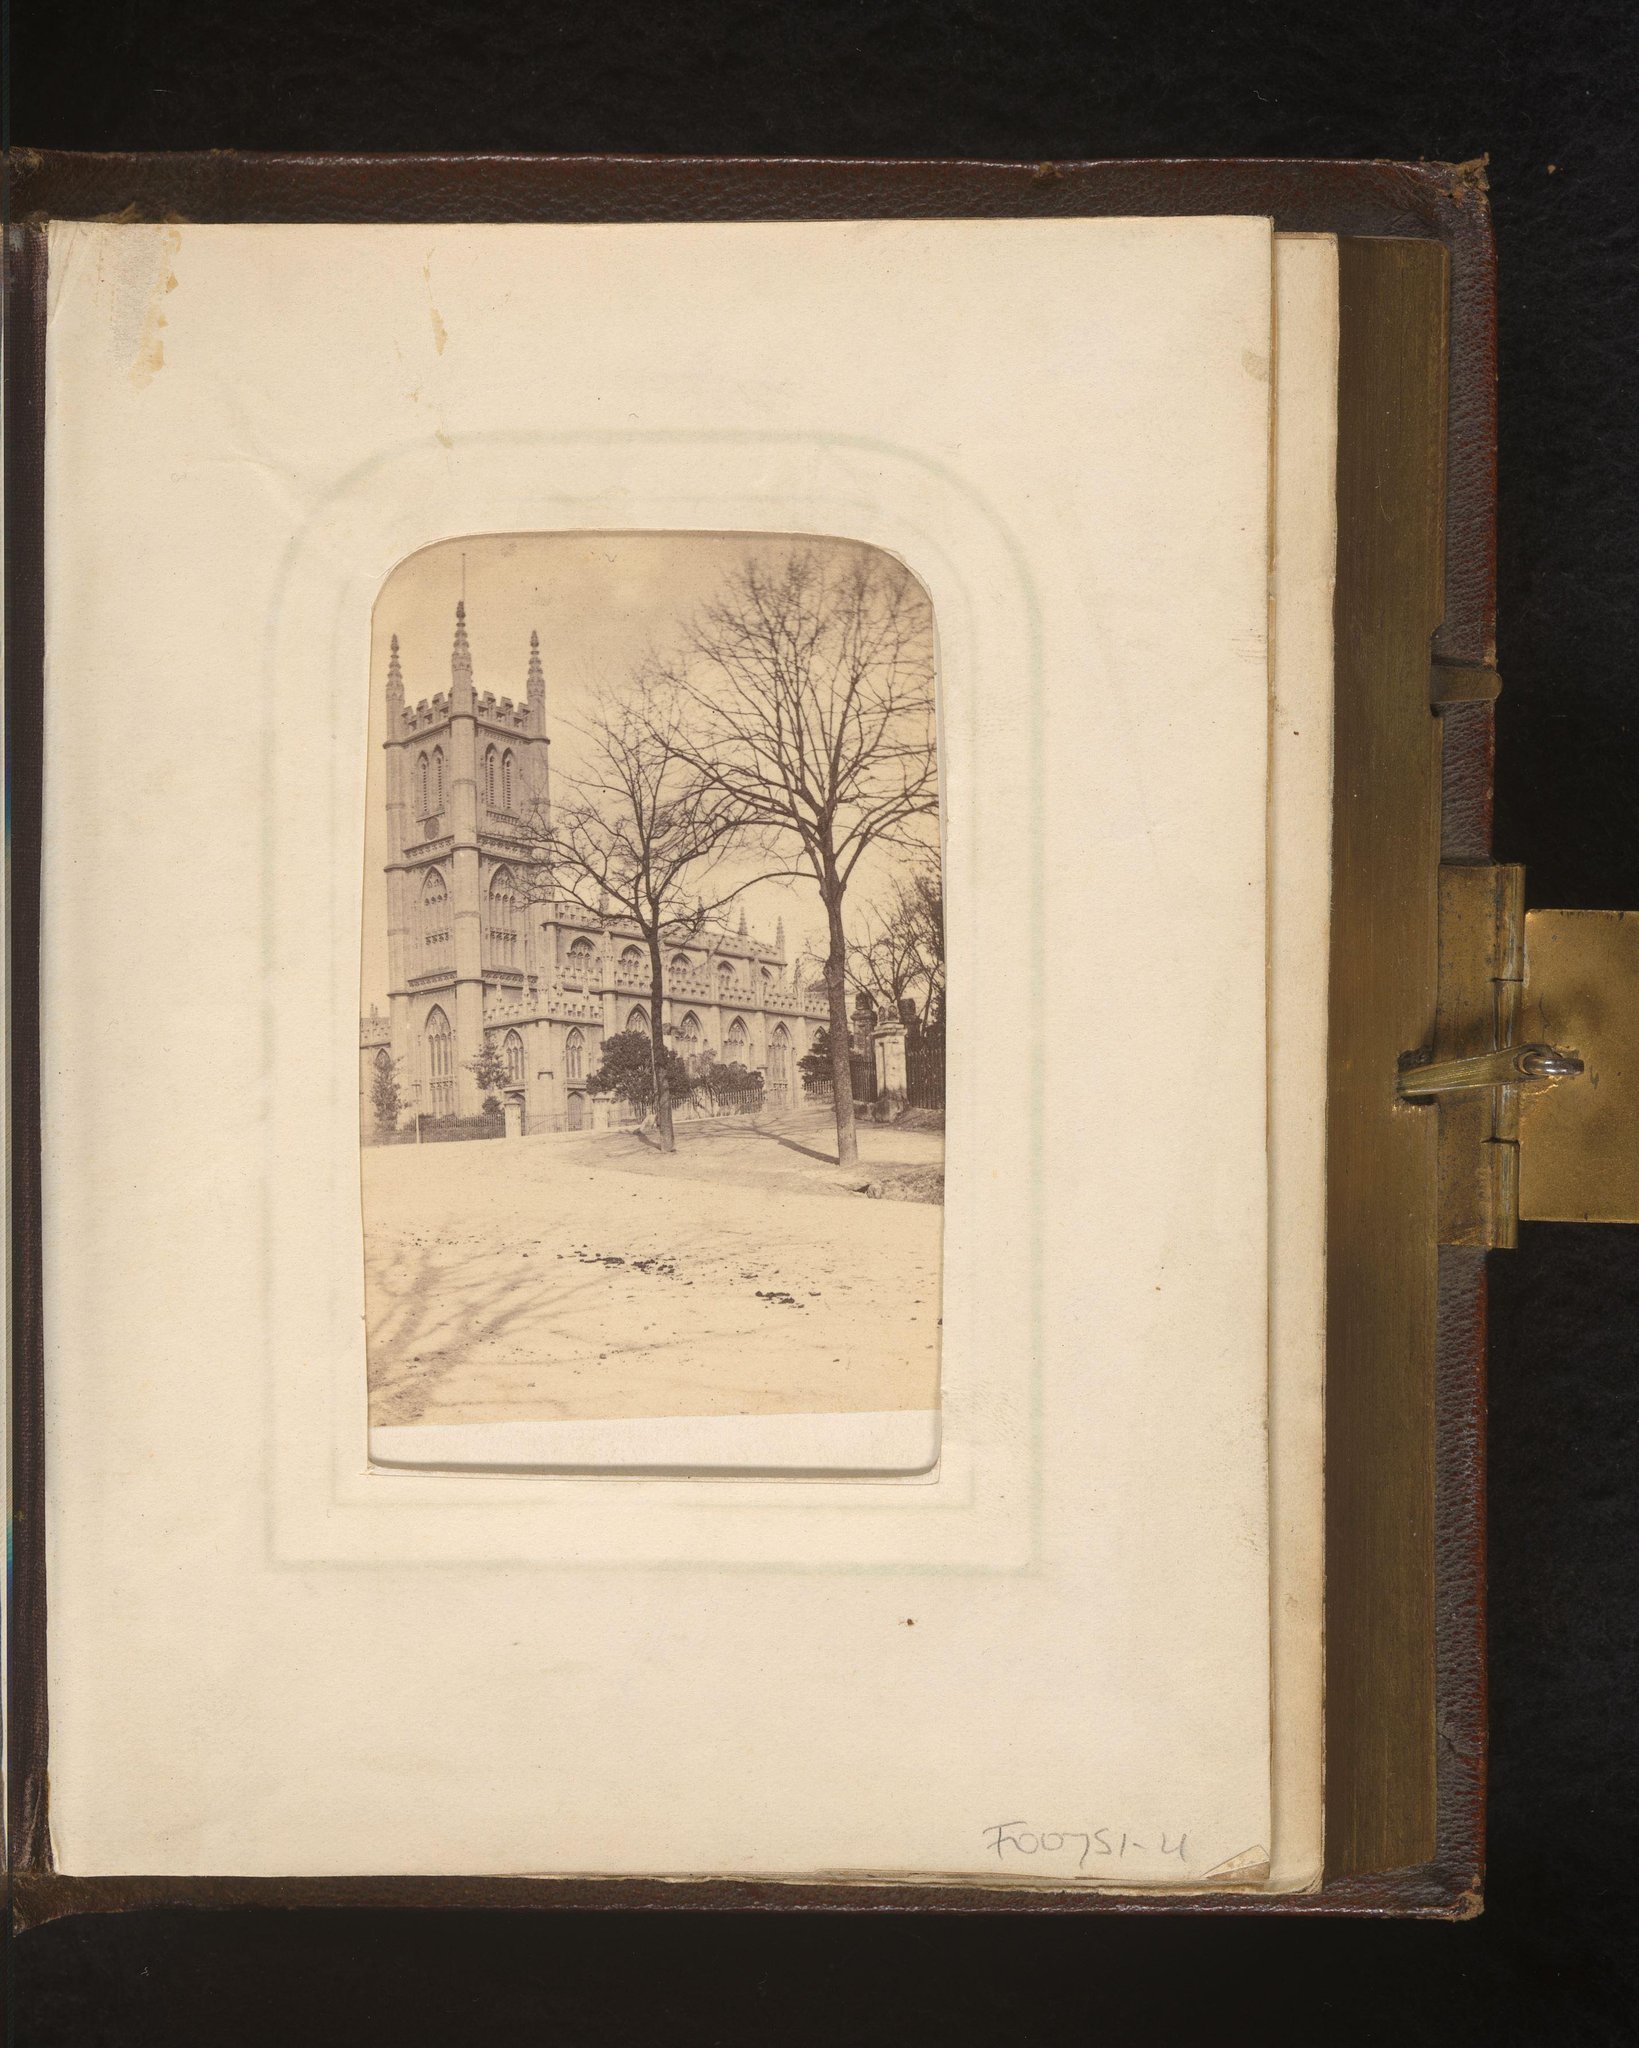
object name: photograph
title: St Mary's Church te Bathwick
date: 1860-1900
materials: cardboard, photographic support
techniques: albumen print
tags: trees, church (exterior)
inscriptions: inscription: ‘J & J. Dutton/ late Dawson and Dutton/ 44 Milsom St./ Bath’, annotation: ‘353 St Mary, Bathwick’